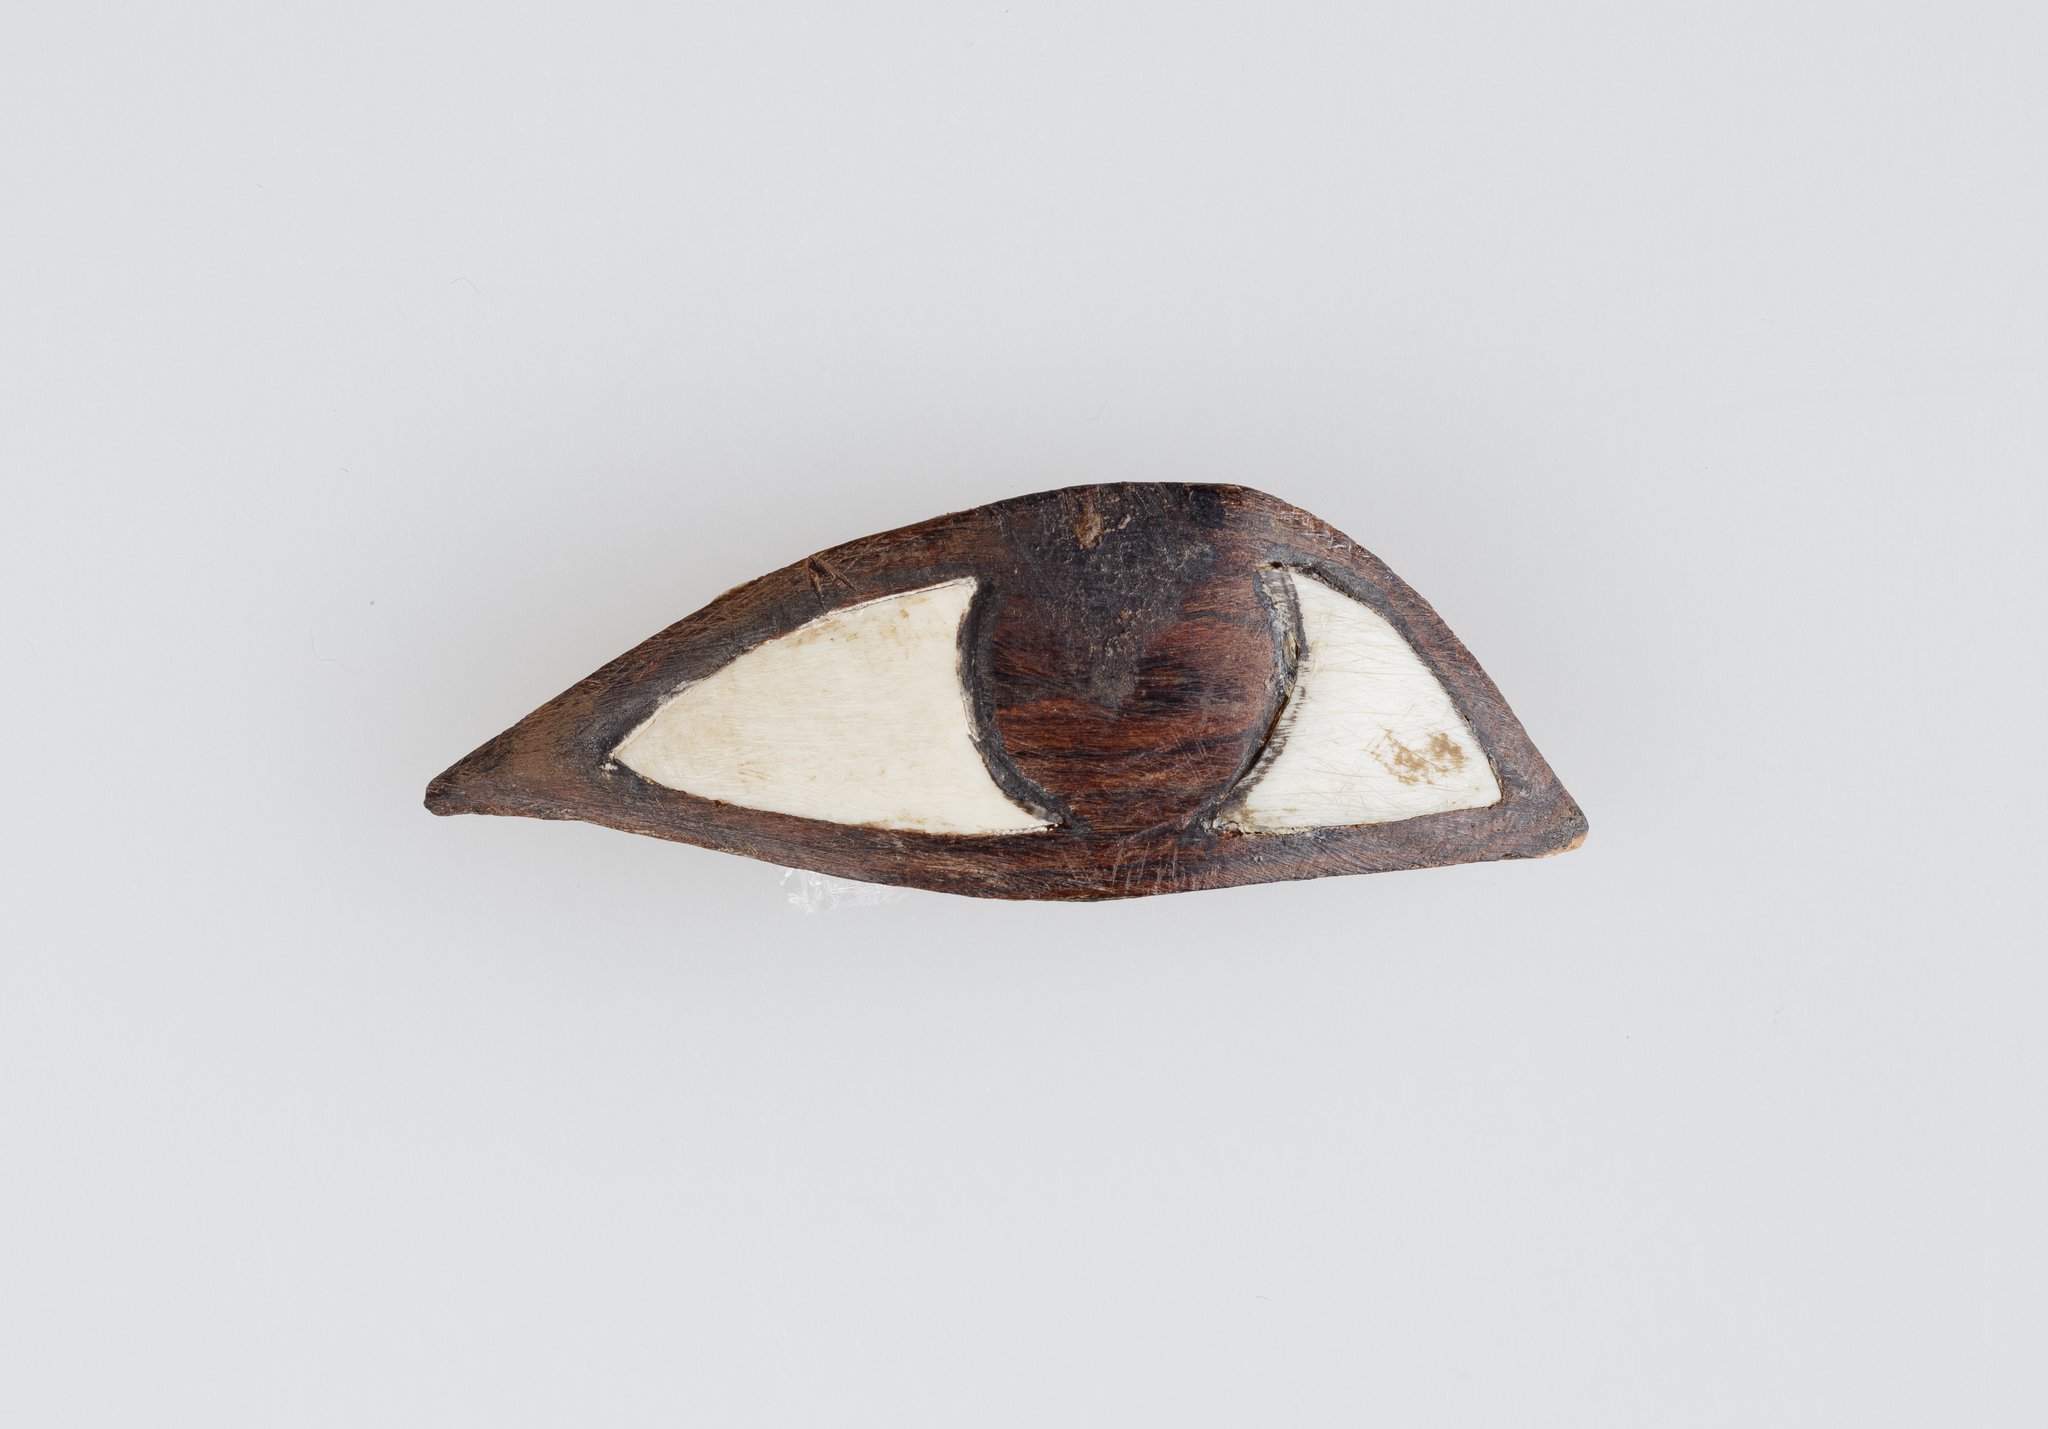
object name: inlay, eye,,,, asdfsdf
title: Eye inlay from coffin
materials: wood, ivory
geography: egypt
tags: eyes